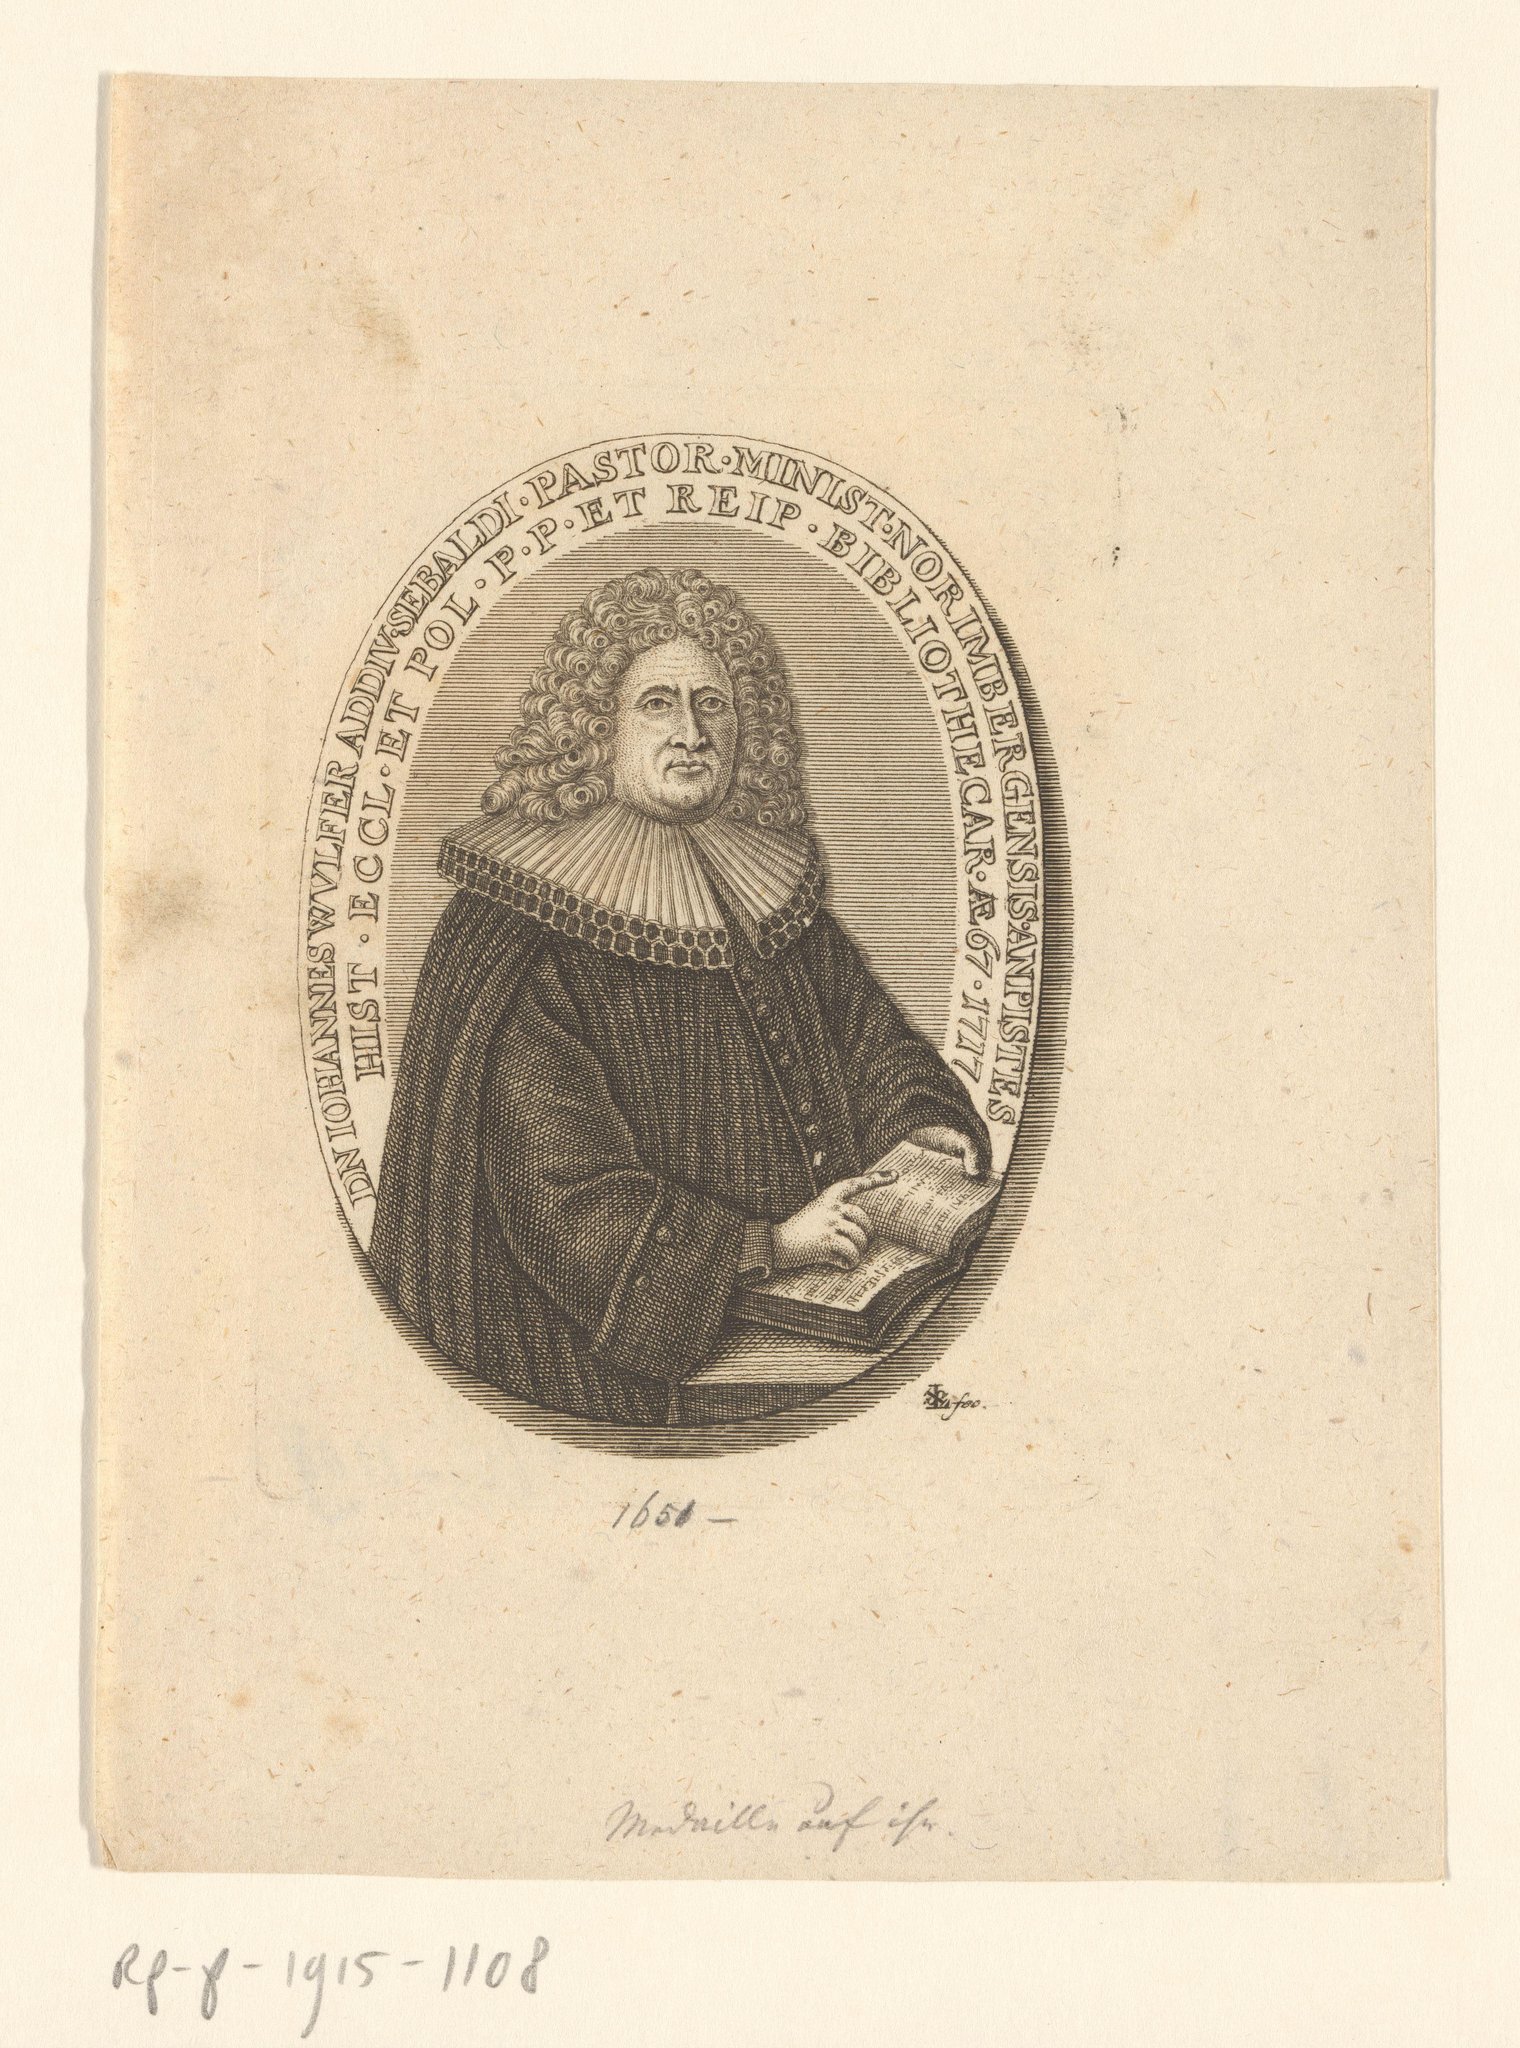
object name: print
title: portret van Johannes Wülfer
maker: johann sebastian leitner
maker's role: print maker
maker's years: 1715-1795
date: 1717-1795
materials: paper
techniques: etching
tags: johannes wülfer, theologian, historical persons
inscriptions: collector's mark: Lugt 2228